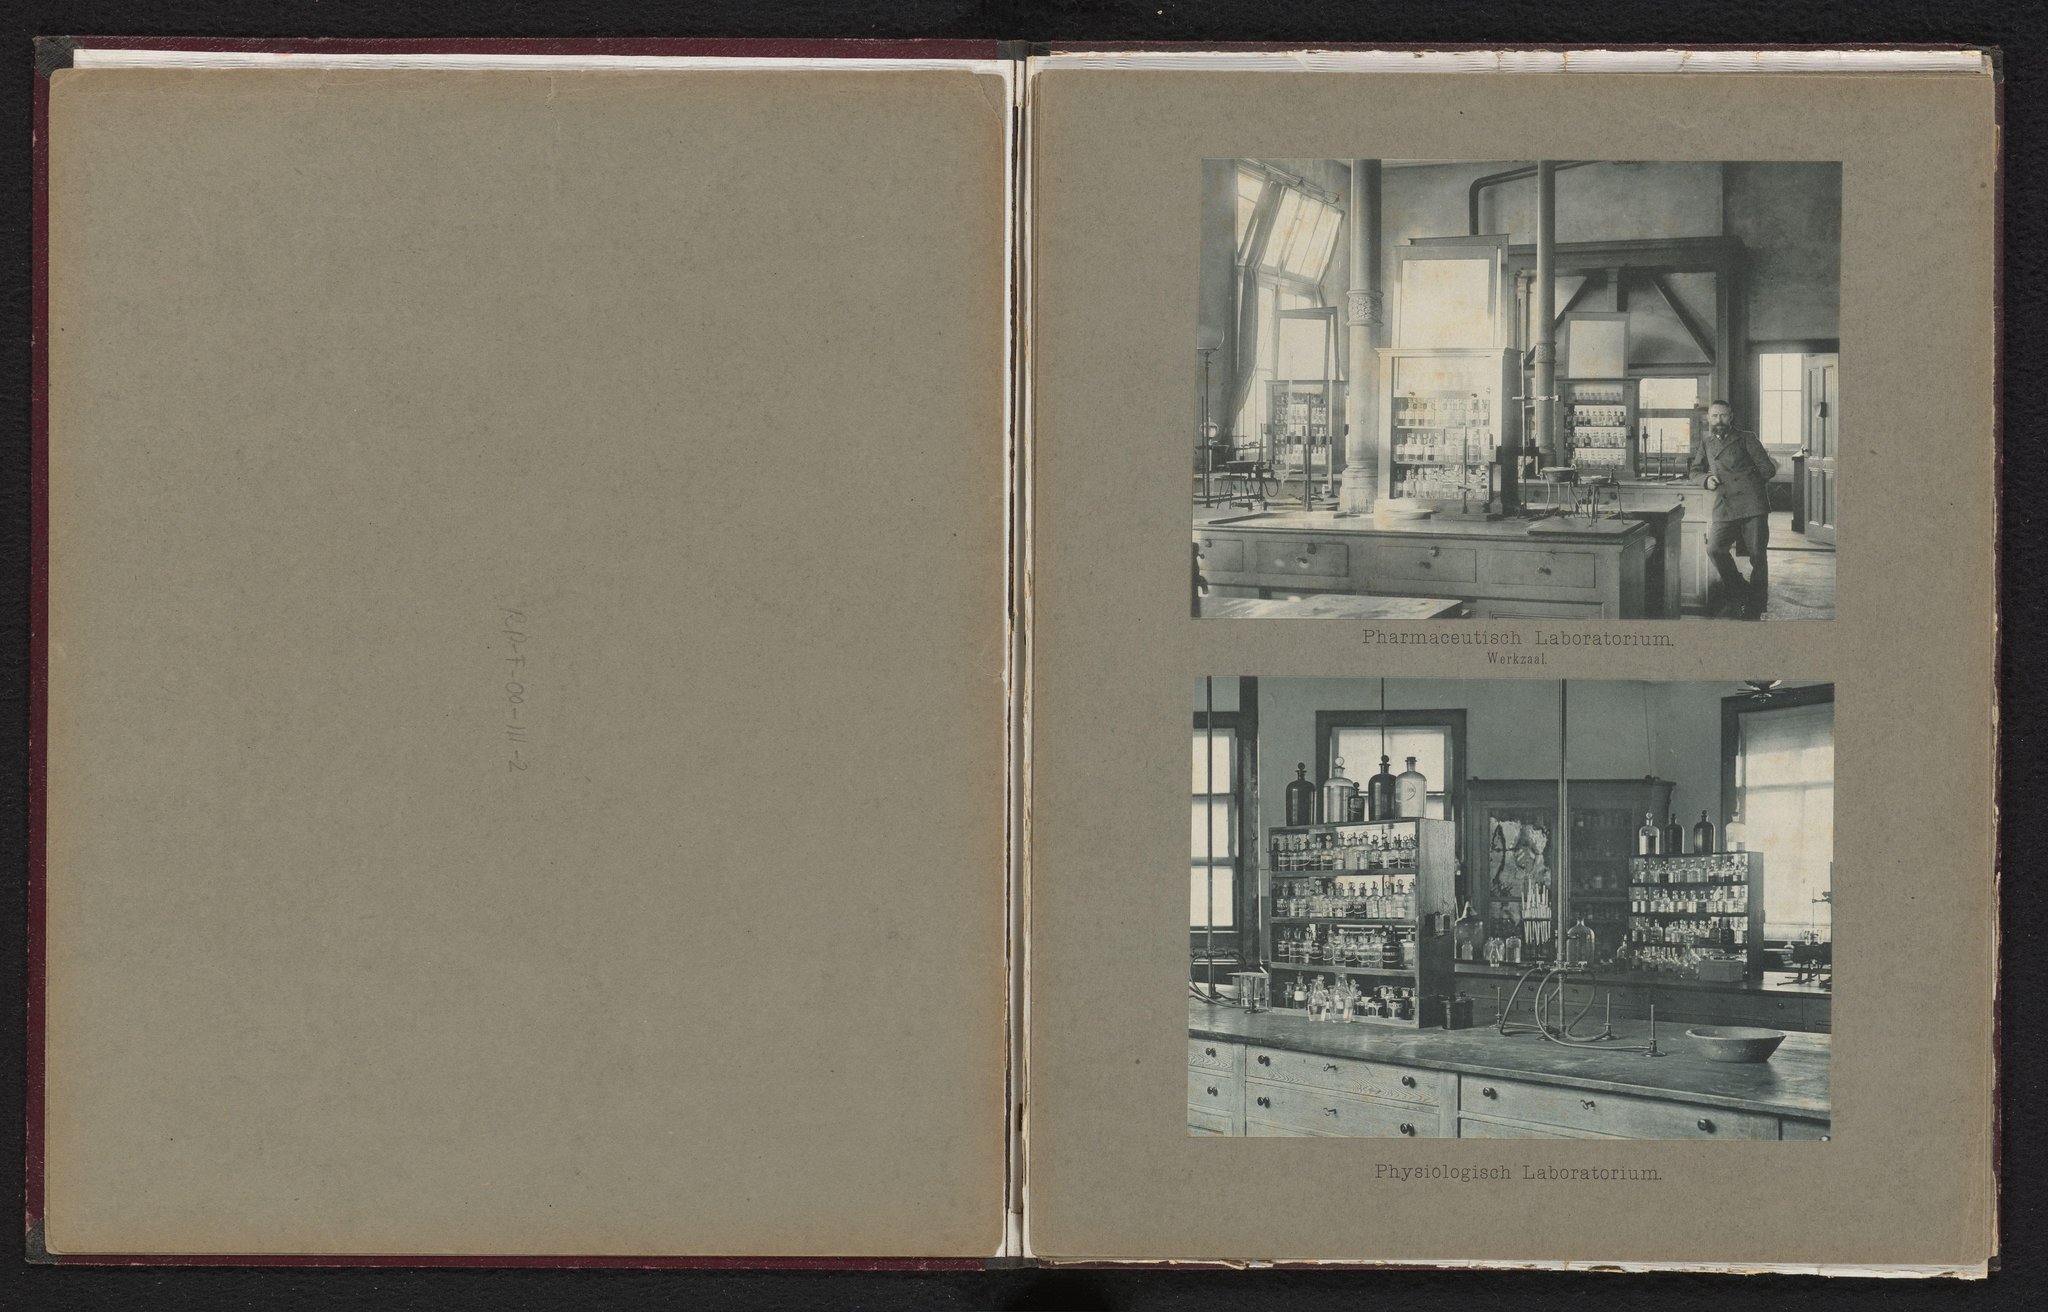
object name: photomechanical print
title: Pharmaceutisch Laboratorium. Werkzaal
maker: Anonymous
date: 1902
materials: cardboard, paper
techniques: photograph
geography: amsterdam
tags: university building, college, laboratory, research room, laboratory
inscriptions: stamp: ‘HISTORISCHE COMMISSIE DER UNIVERSITEIT VAN AMSTERDAM’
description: Deze prent maakt deel uit van een omslag met vijftien lichtdrukken op twaalf kartonnen bladen.